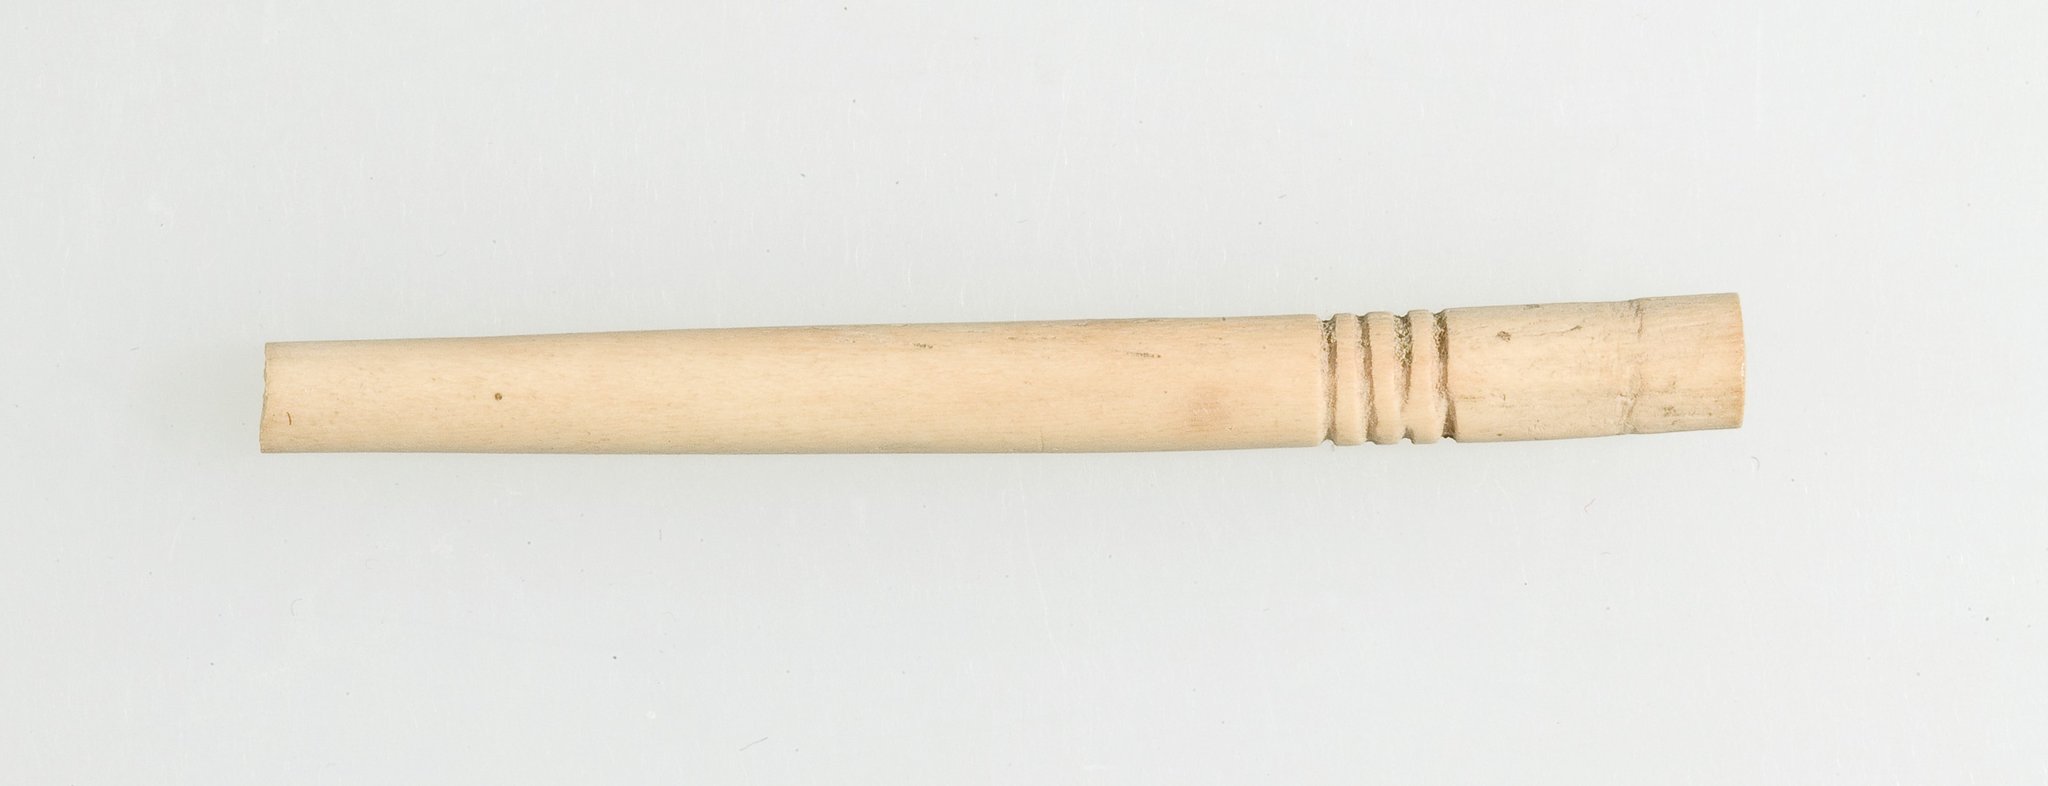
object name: hair pin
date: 1700-1550 BCE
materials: ivory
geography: egypt